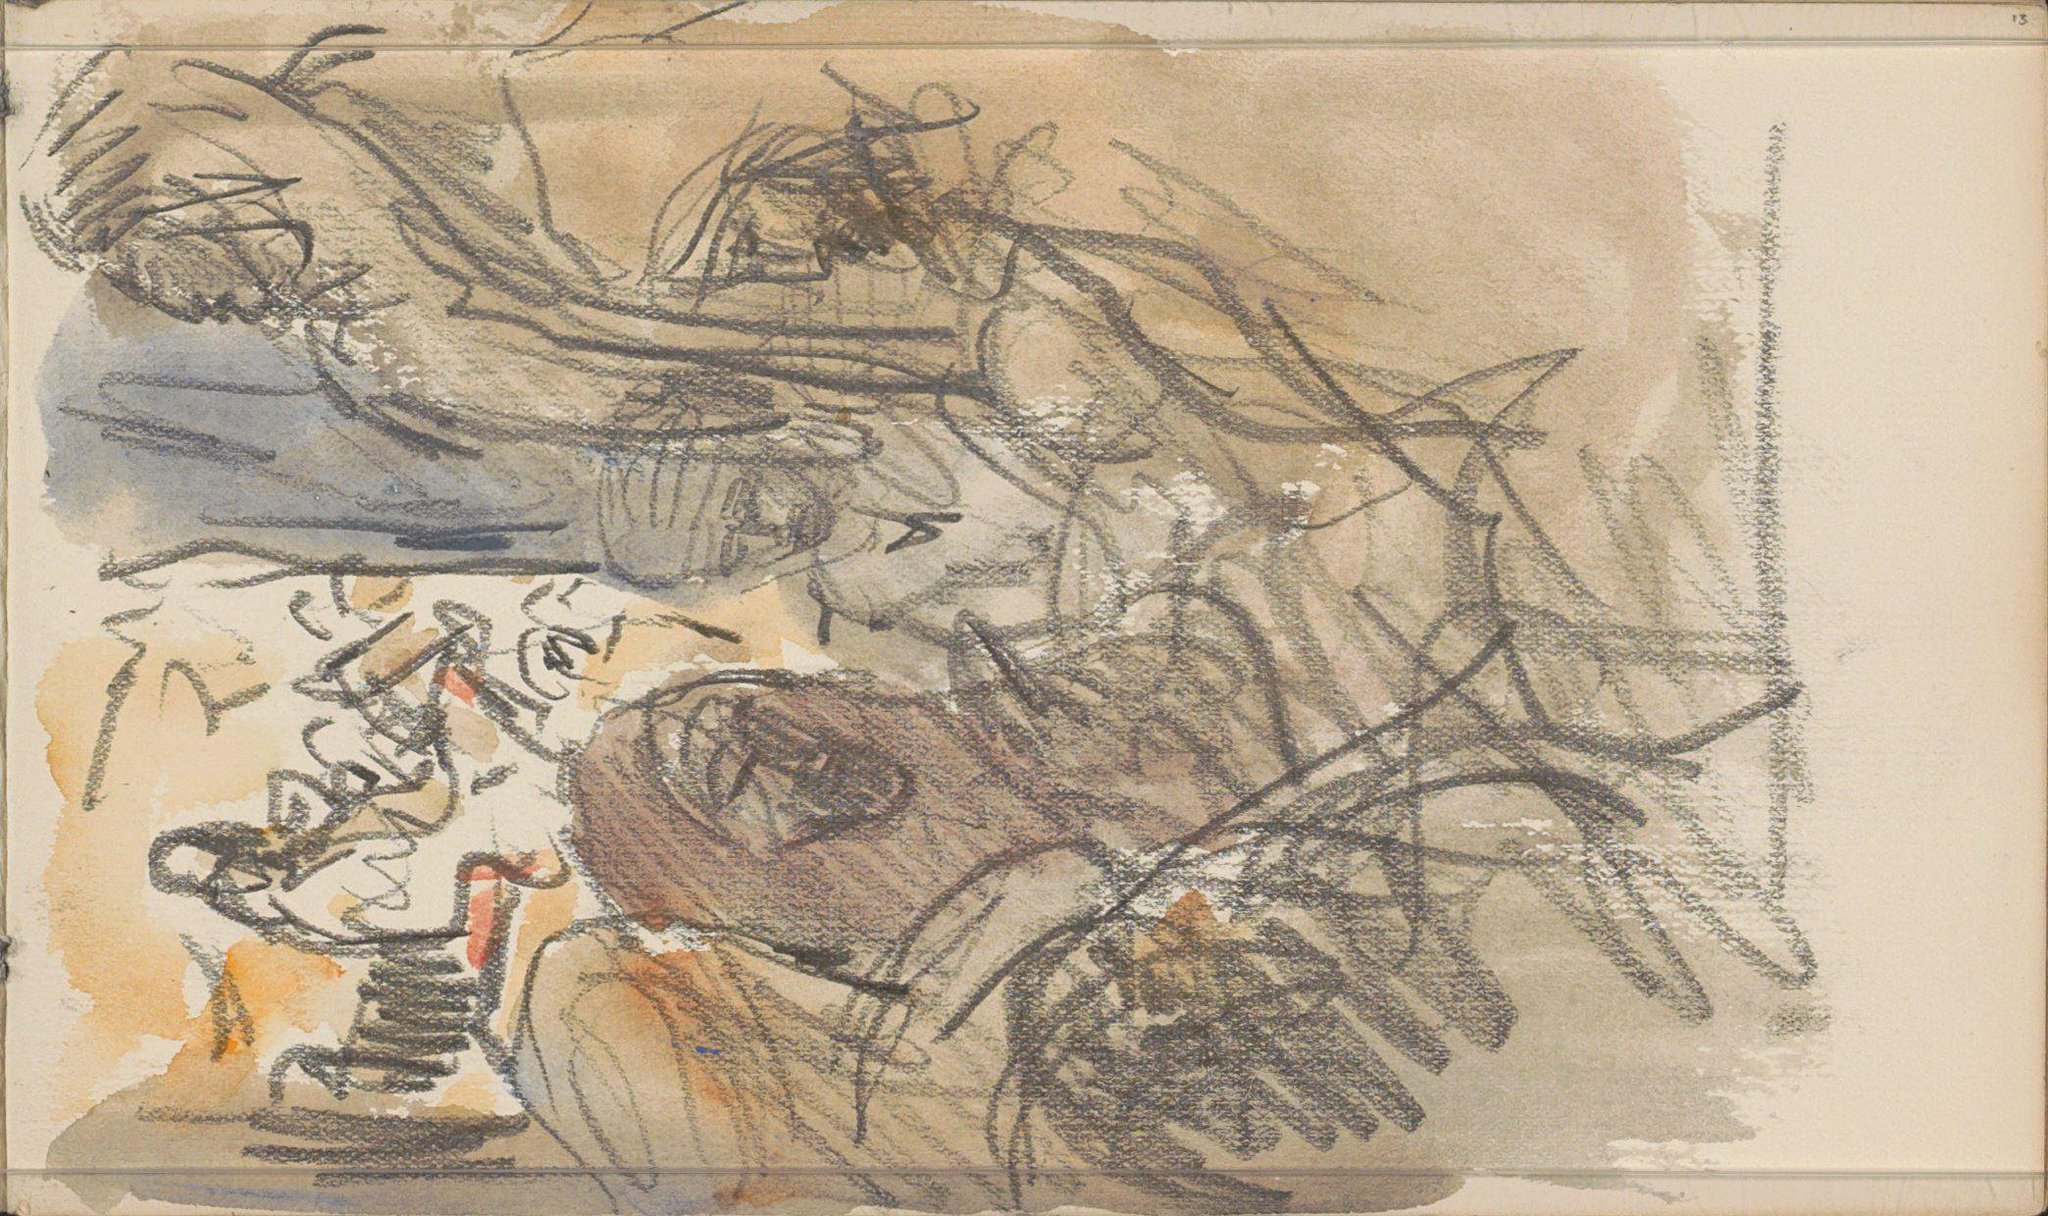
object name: sketchbook leaf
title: Algerijnse mannen in een kring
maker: marius bauer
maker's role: draughtsman, print maker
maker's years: 1867-1932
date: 1922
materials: paper, pencil, watercolor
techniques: brush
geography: algeria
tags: africans, adult man, folk costume, regional costume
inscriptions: kleurnotitie, handgeschreven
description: De figuren dragen traditioneel Noord-Afrikaans kostuum. Mogelijk maken zij deel uit van een Bedoeïenengemeenschap. Pagina 13 uit een schetsboek met 31 bladen.